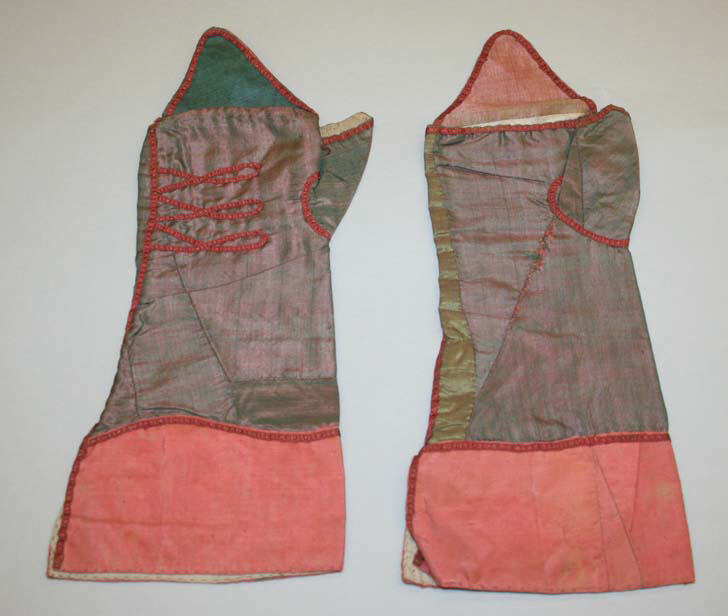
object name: mitt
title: Mitts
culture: european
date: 1701-1800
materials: silk